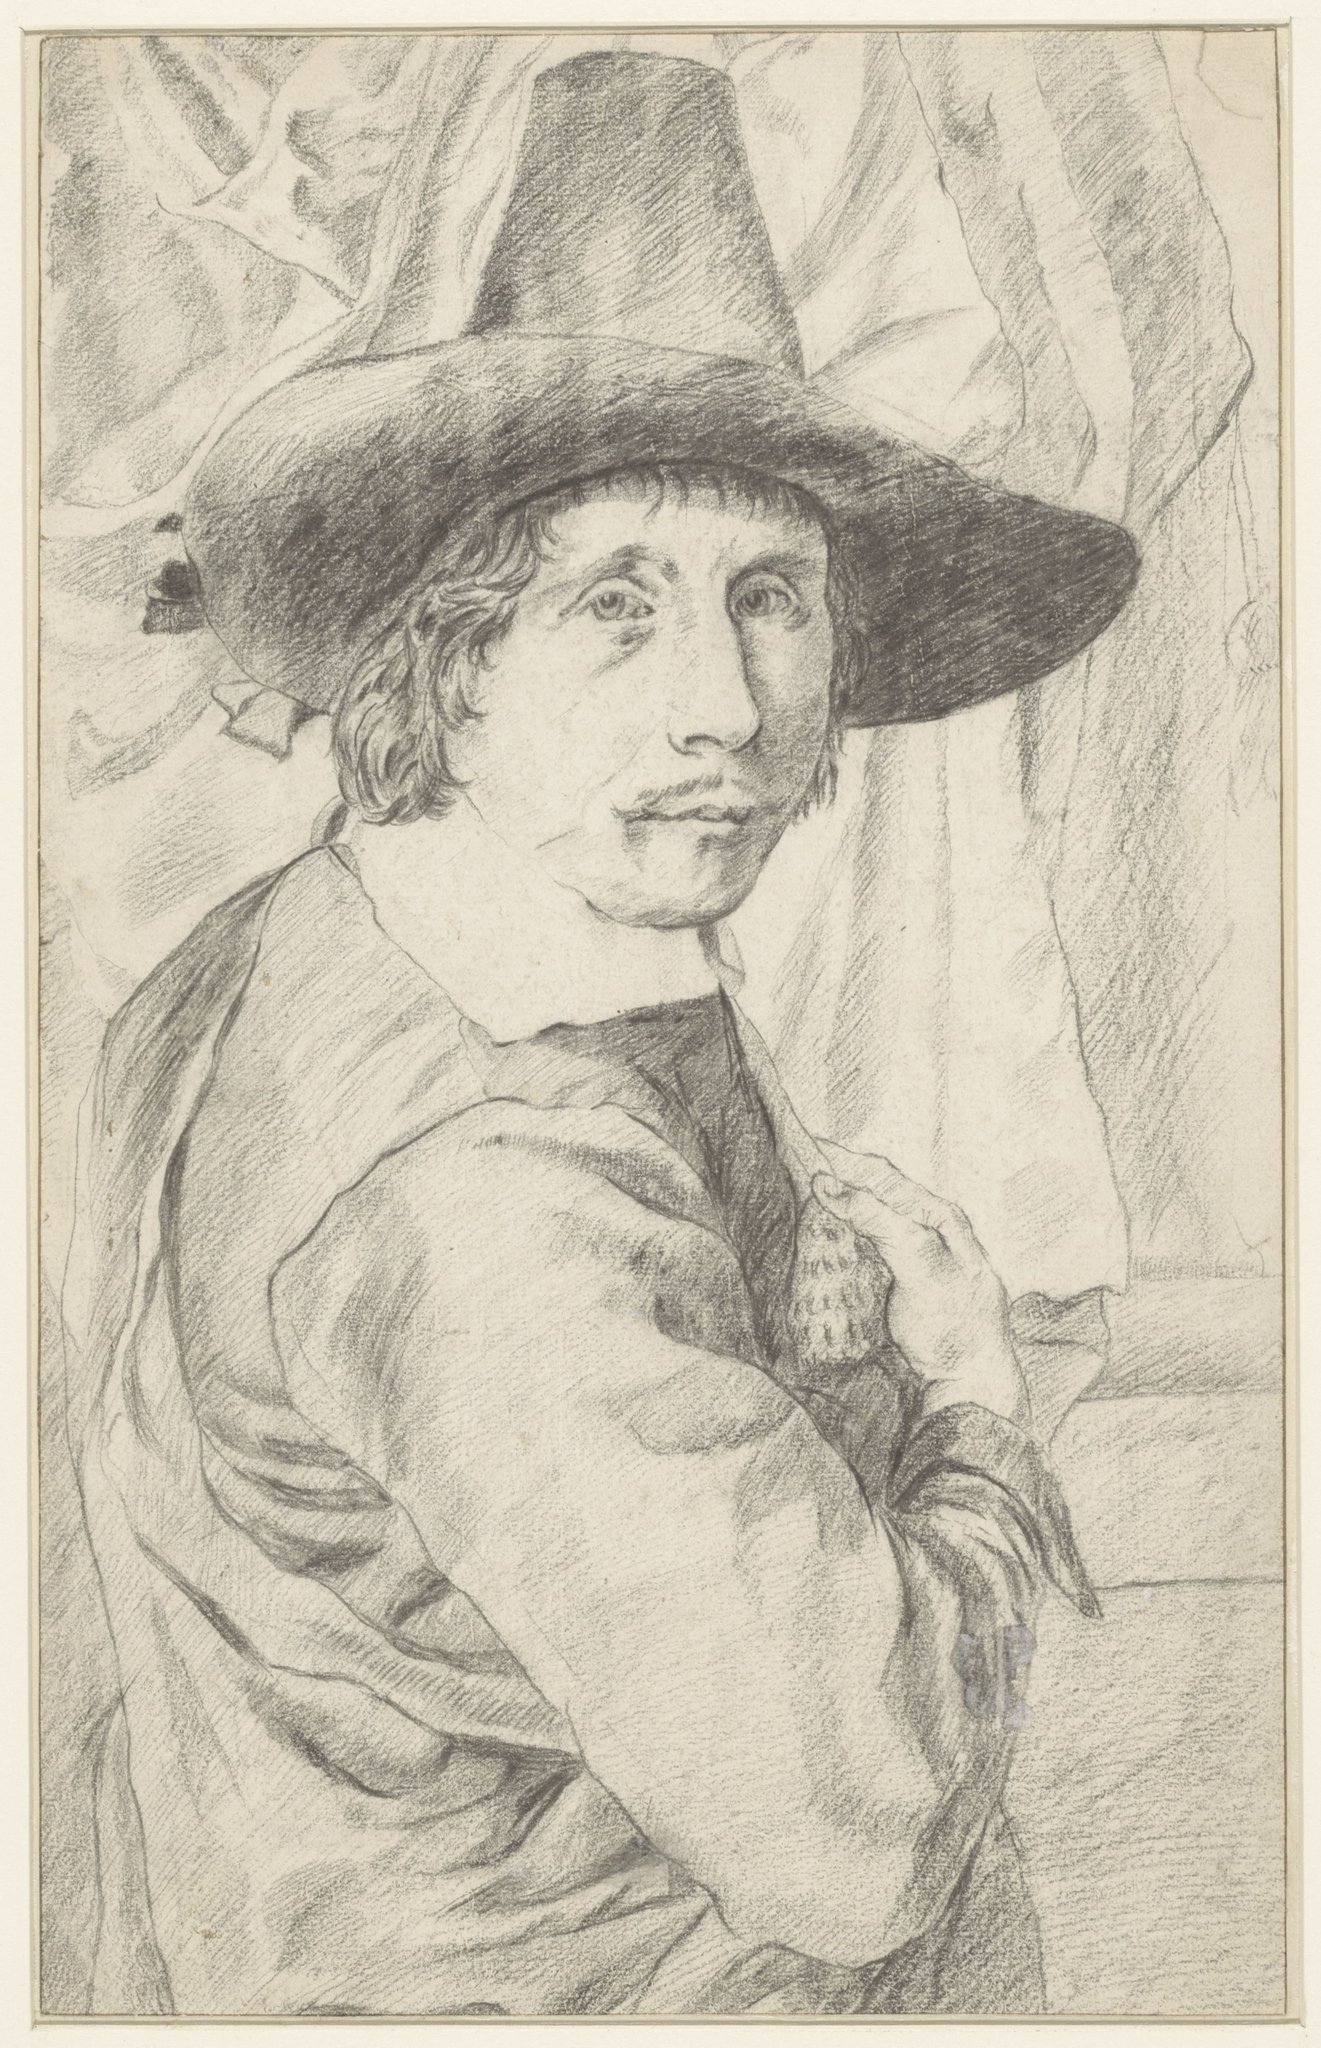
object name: drawing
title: Portret van Laurens van der Vinne (I)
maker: Anonymous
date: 1658-1729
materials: chalk, paper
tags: haarlem, print maker, draughtsman, laurens vincentsz. van der vinne, historical persons, portrait, self-portrait of artist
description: Portret van Laurens van der Vinne I (1658-1729).